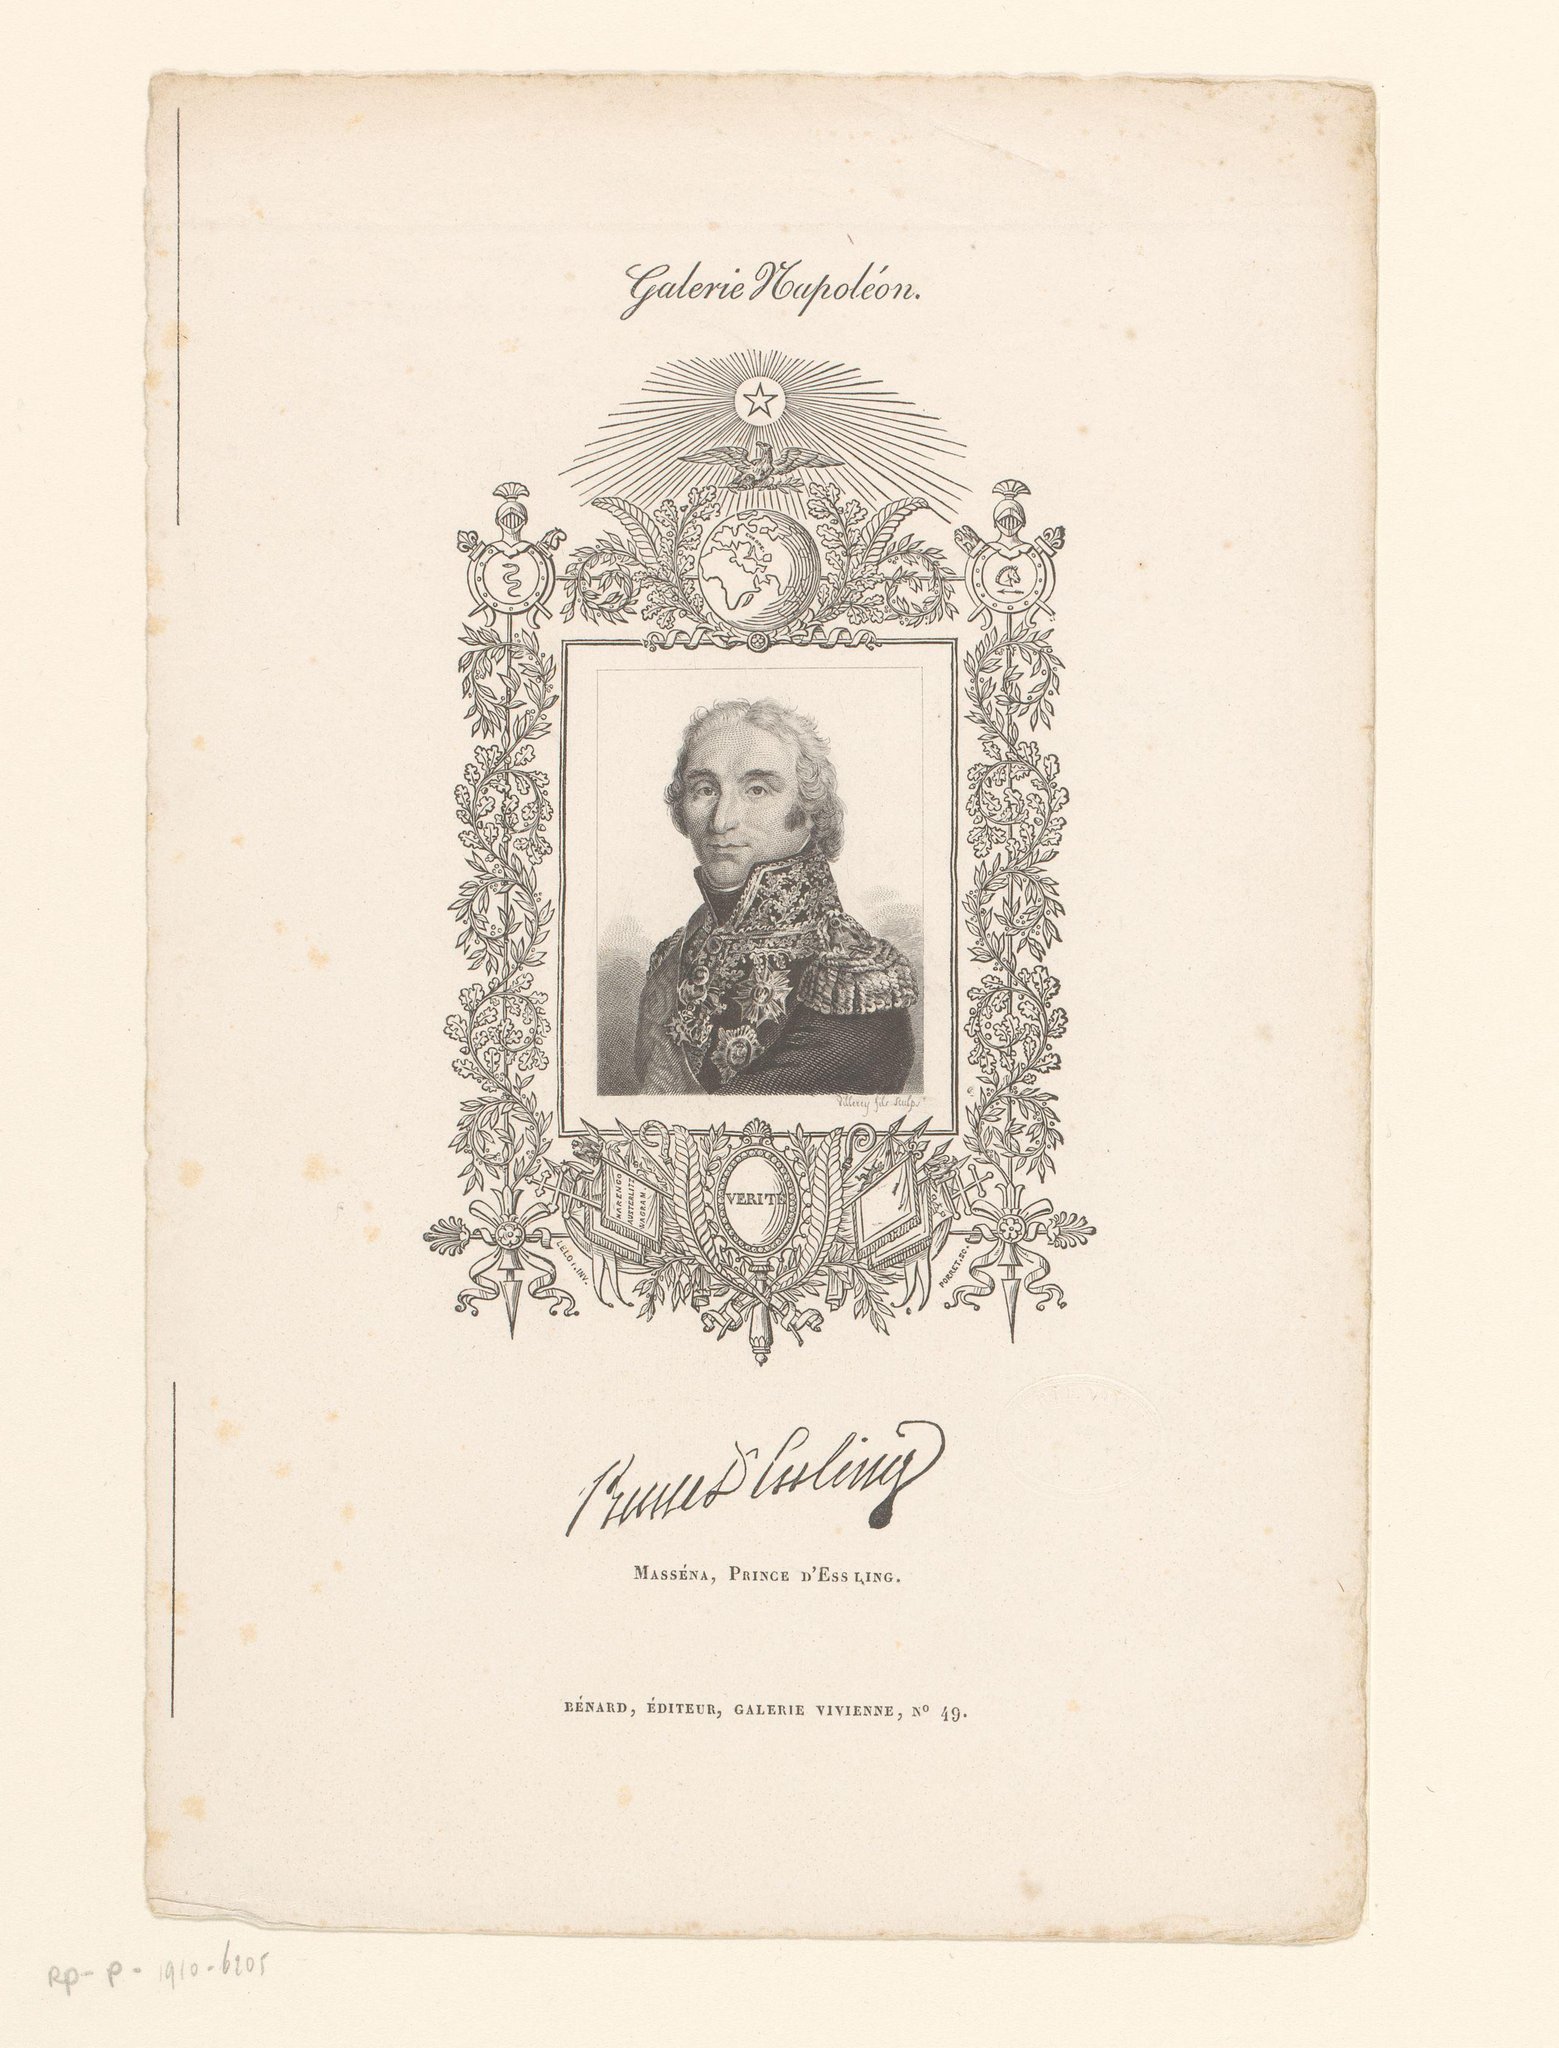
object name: print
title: Portret van André Masséna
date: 1829-1830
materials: paper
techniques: etching, engraving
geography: paris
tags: commander-in-chief, general, marshal, historical persons, globe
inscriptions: check stamp: ‘Galerie Vivienne/ no: 49 /Bénard’, collector's mark: Lugt 2228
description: Dit portret maakt deel uit van de serie "Galerie Napoléon", een collectie van honderd portretten van vooraanstaande figuren uit de omgeving van Napoleon Bonaparte. De serie werd uitgegeven door Bénard in Parijs in 1829-30.